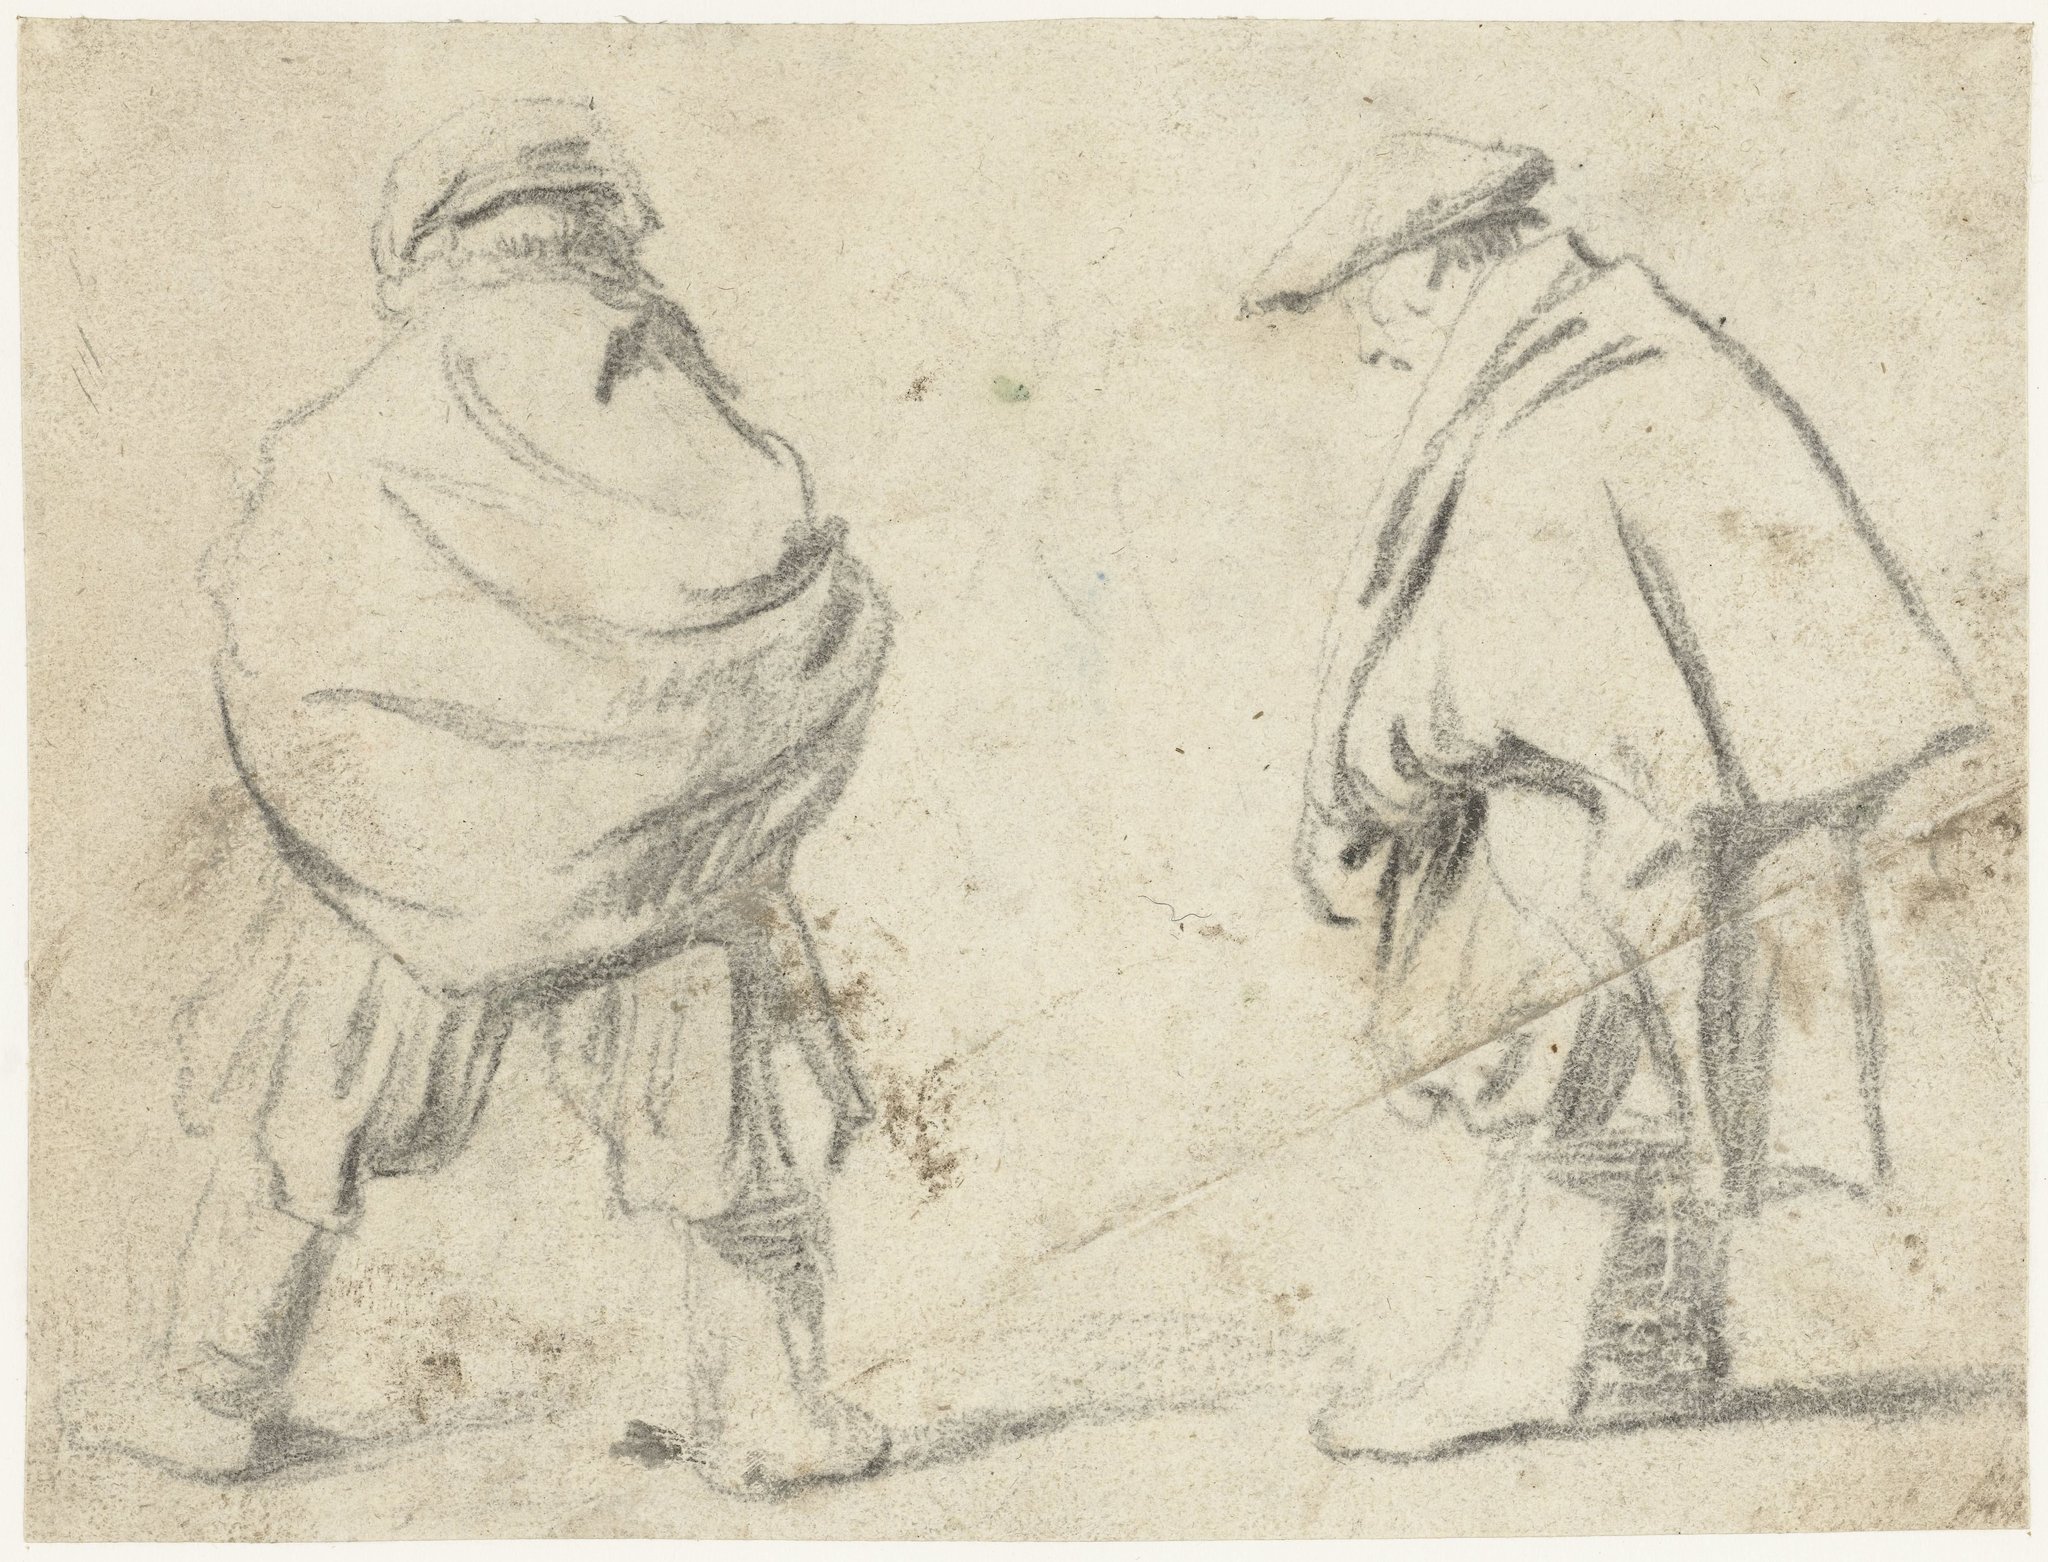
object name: drawing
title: Studieblad van een staande urinerende man, van achteren en van opzij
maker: gerard ter borch (ii)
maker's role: draughtsman, painter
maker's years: 1617-1681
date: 1627-1681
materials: chalk, paper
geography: zwolle